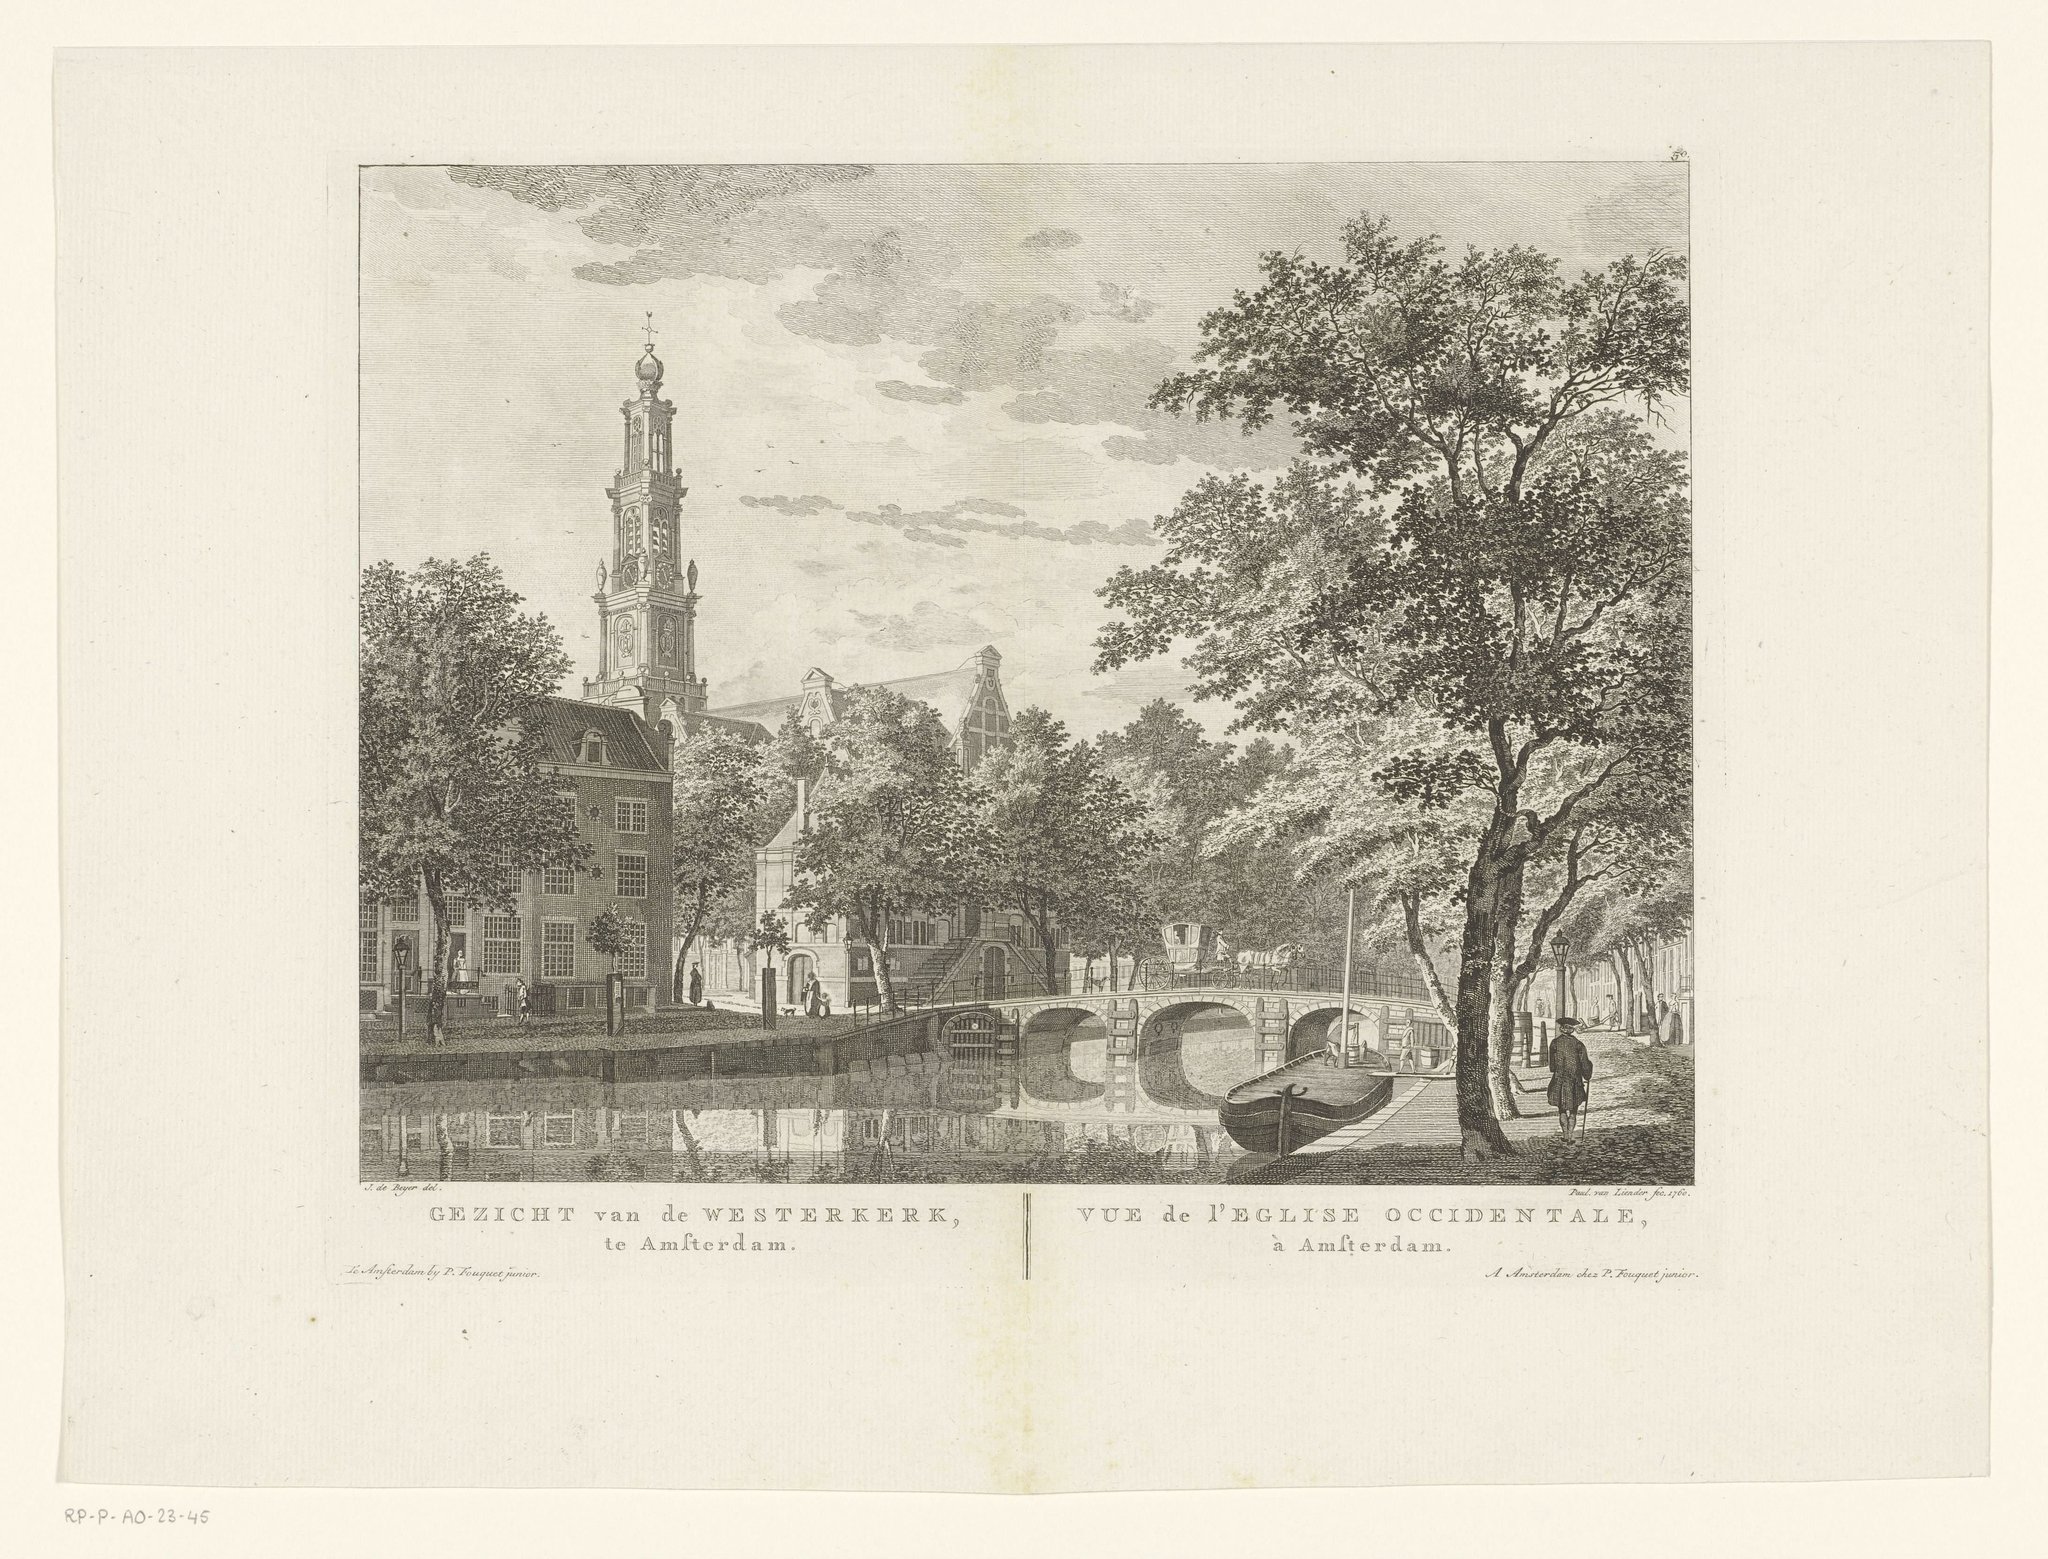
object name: print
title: Gezicht op de Westerkerk en Westerhal, gezien vanaf de Keizersgracht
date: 1760-1783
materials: paper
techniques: engraving, etching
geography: amsterdam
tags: bridge in city across river, canal, etc. (+ city(-scape) with figures, staffage), church (exterior), canals, waters (in city), weigh-house, market-hall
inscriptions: collector's mark: Lugt 2228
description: Deze prent is ook gebruikt in de zogenaamde Atlas van Fouquet.* Pierre Fouquet gaf vanaf 1760 stadsgezichten van Amsterdam - naar tekeningen van verschillende kunstenaars, gemaakt door verschillende prentmakers - uit. Deze prenten werden aanvankelijk los of in series verkocht. Zoals toen gebruikelijk kon de koper de prenten zelf laten inbinden. Hiertoe gaf Fouquet tussen 1778 en 1783 een titelblad, plattegrond en inhoudsopgave van de tot dusver 100 uitgegeven prenten uit (1). Gezien de inhoud afhankelijk was van wat de koper had verzameld verschilt de inhoud van de verschillende bewaarde Fouquetatlassen onder deze titel sterk. Ook zijn er exemplaren bekend waar tevens andere prenten aan zijn toegevoegd. Omdat er behoefte bleek aan uitleg bij de platen werd in 1783 een nieuwe versie van de atlas uitgegeven, aangevuld met tekst en twee prenten. De aangegeven volgorde veranderde maar de platen van de al eerder uitgegeven prenten bleven ongewijzigd. Deze uitgave werd in opdracht van Fouquet gedrukt bij Daniël Jean Changuion en Petrus den Hengst (2). Een tiental platen werd bijgewerkt en verscheen, met nieuw impressum, in het vervolg van Wagenaars geschiedenis van Amsterdam, uitgeven door Petrus Conradi en Folkert van der Plaats (3). Een aantal jaar na het overlijden van Fouquet kwam Evert Maaskamp met een nieuwe uitgave van de atlas, met verbeterde tekst en toevoeging van twee prenten. Op alle platen verwijderde hij het oude en liet hij zijn eigen impressum zetten (4). De huidige staat van de prent komt voor in exemplaren van de onder (1) en (2) genoemde werken. * Onder de Atlas van Fouquet of Fouquetatlas verstaan we de hieronder vermelde publicaties (1), (2) en (4). (1). Afbeeldingen van de wyd-vermaarde koopstad Amsterdam benevens des zelvs voornaamste gebouwen en gezigten alle naar het leeven getekend / Receuil des edifices les plus considerables et des plus belles vues, de la fameuse ville d'Amsterdam, dessinées d'après nature. Amsterdam: Pierre Fouquet, 1778-1783. (2). Nieuwe atlas, van de voornaamste gebouwen en gezigten der stad Amsterdam, met derzelver beknopte beschryvingen. 2 delen. Amsterdam: Daniël Jean Changuion en Petrus den Hengst [in opdracht van Pierre Fouquet], 1783. (3). Stijl, Simon. Amsterdam, in zyne geschiedenissen, voorregten, koophandel, gebouwen, kerkenstaat, schoolen, schutterye, gilden en regeeringe, beschreeven. Om te dienen ten vervolge op het werk van Jan Wagenaar (…). 10 delen. Amsterdam en Harlingen: Petrus Conradi en Folkert van der Plaats, 1788-1801. (4). Nieuwe atlas, van de voornaamste gebouwen en gezigten der stad Amsterdam. Met derzelver beknopte beschryvingen. Amsterdam: Evert Maaskamp, 1805. * Het aantal vermelde staten is gebaseerd op het aantal gevonden staten. Mogelijk zijn er meer staten van deze prent.